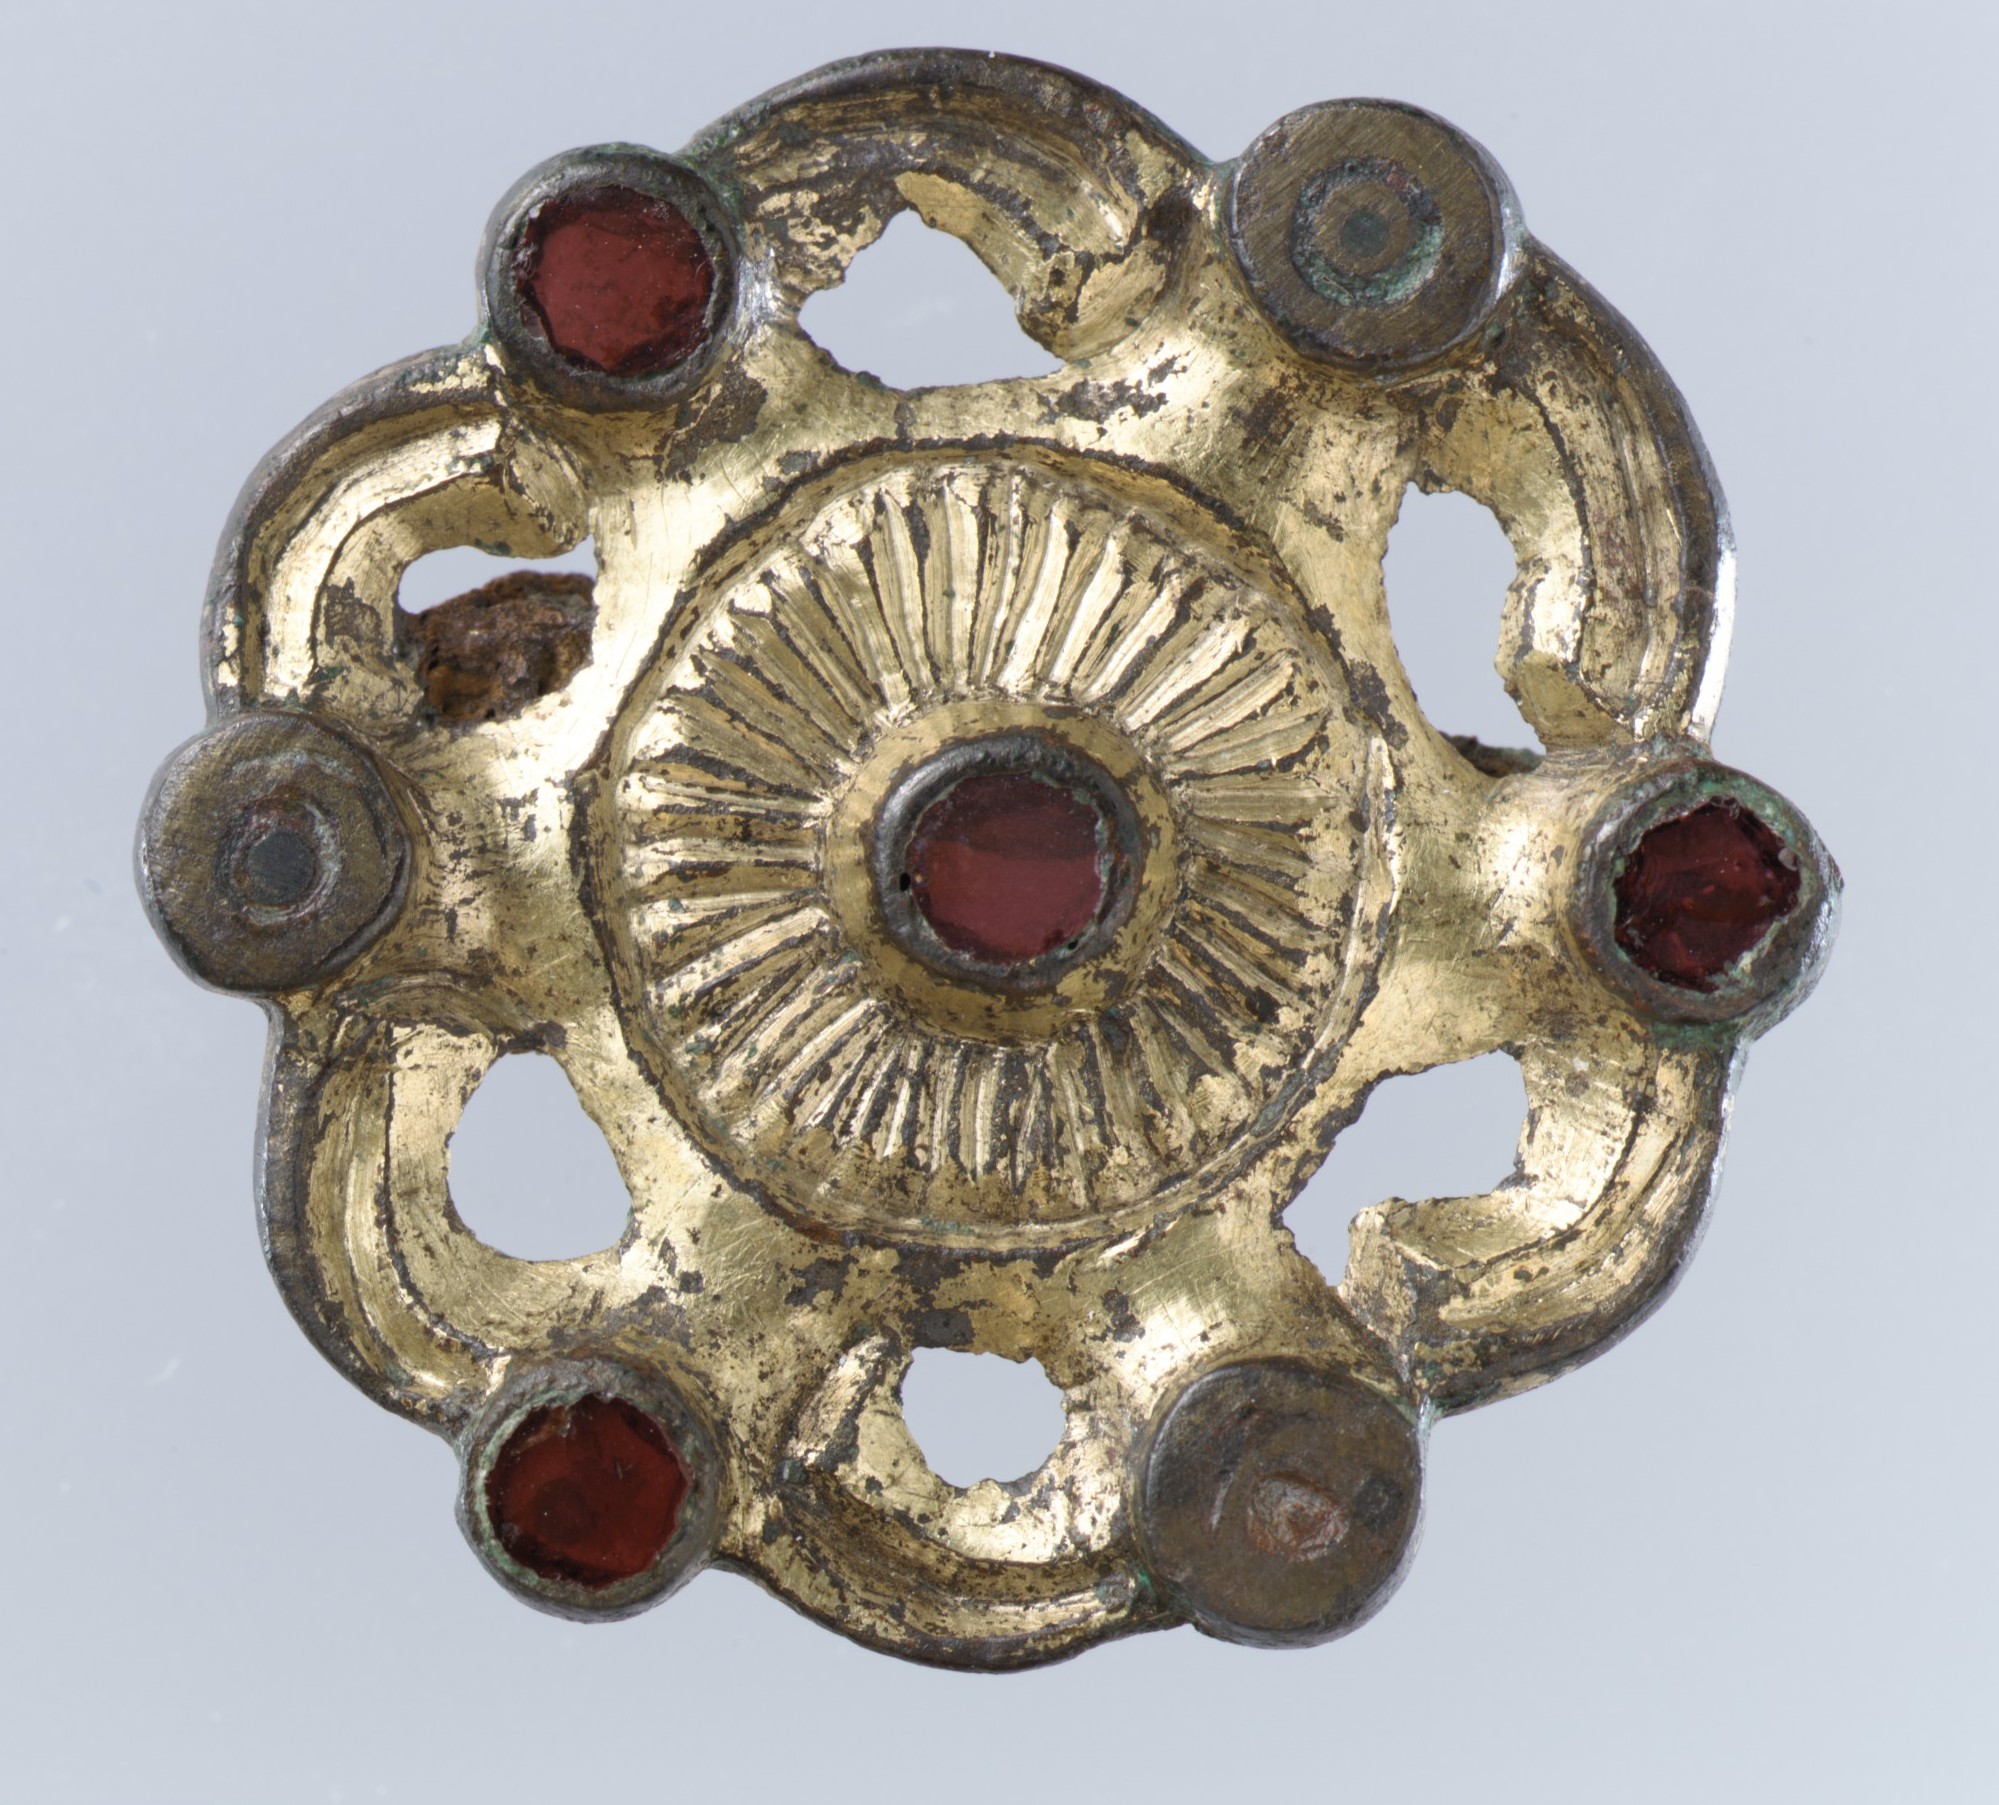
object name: brooch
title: Whorl-Shaped Brooch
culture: frankish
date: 550-650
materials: copper alloy, gemstone, niello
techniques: gilding